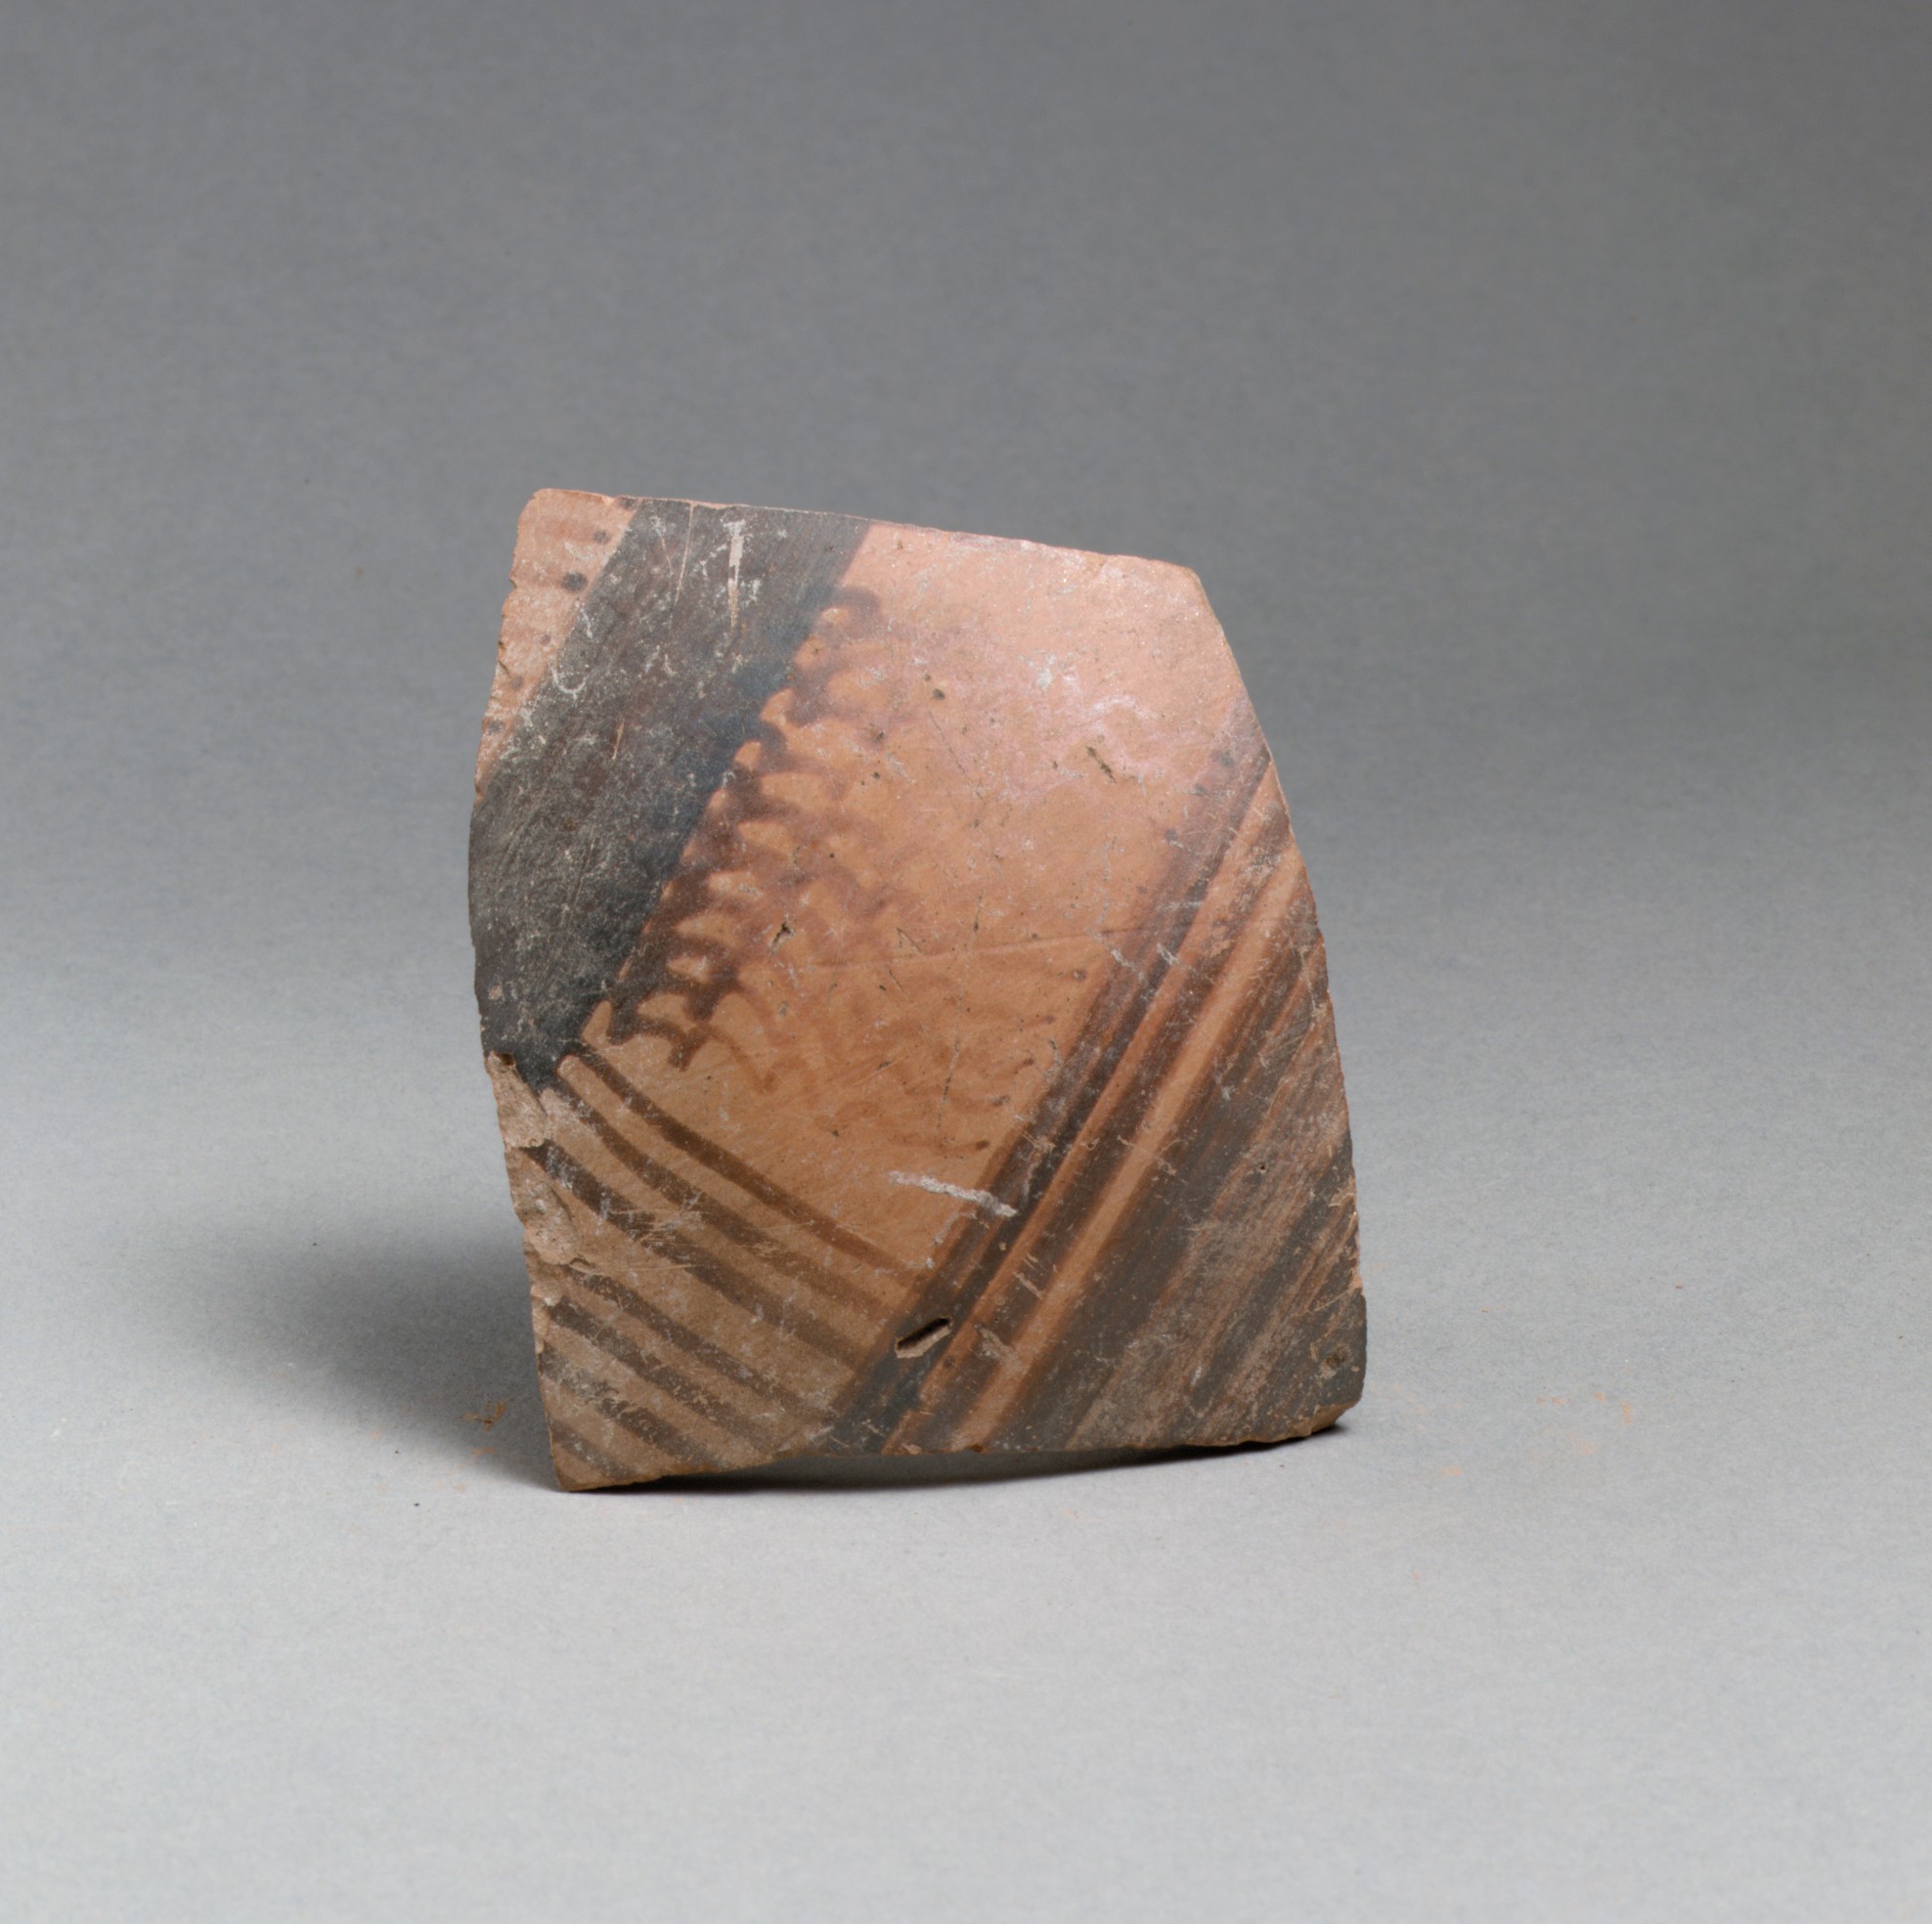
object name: vase fragment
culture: greek or lydian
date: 1050-700 BCE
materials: terracotta